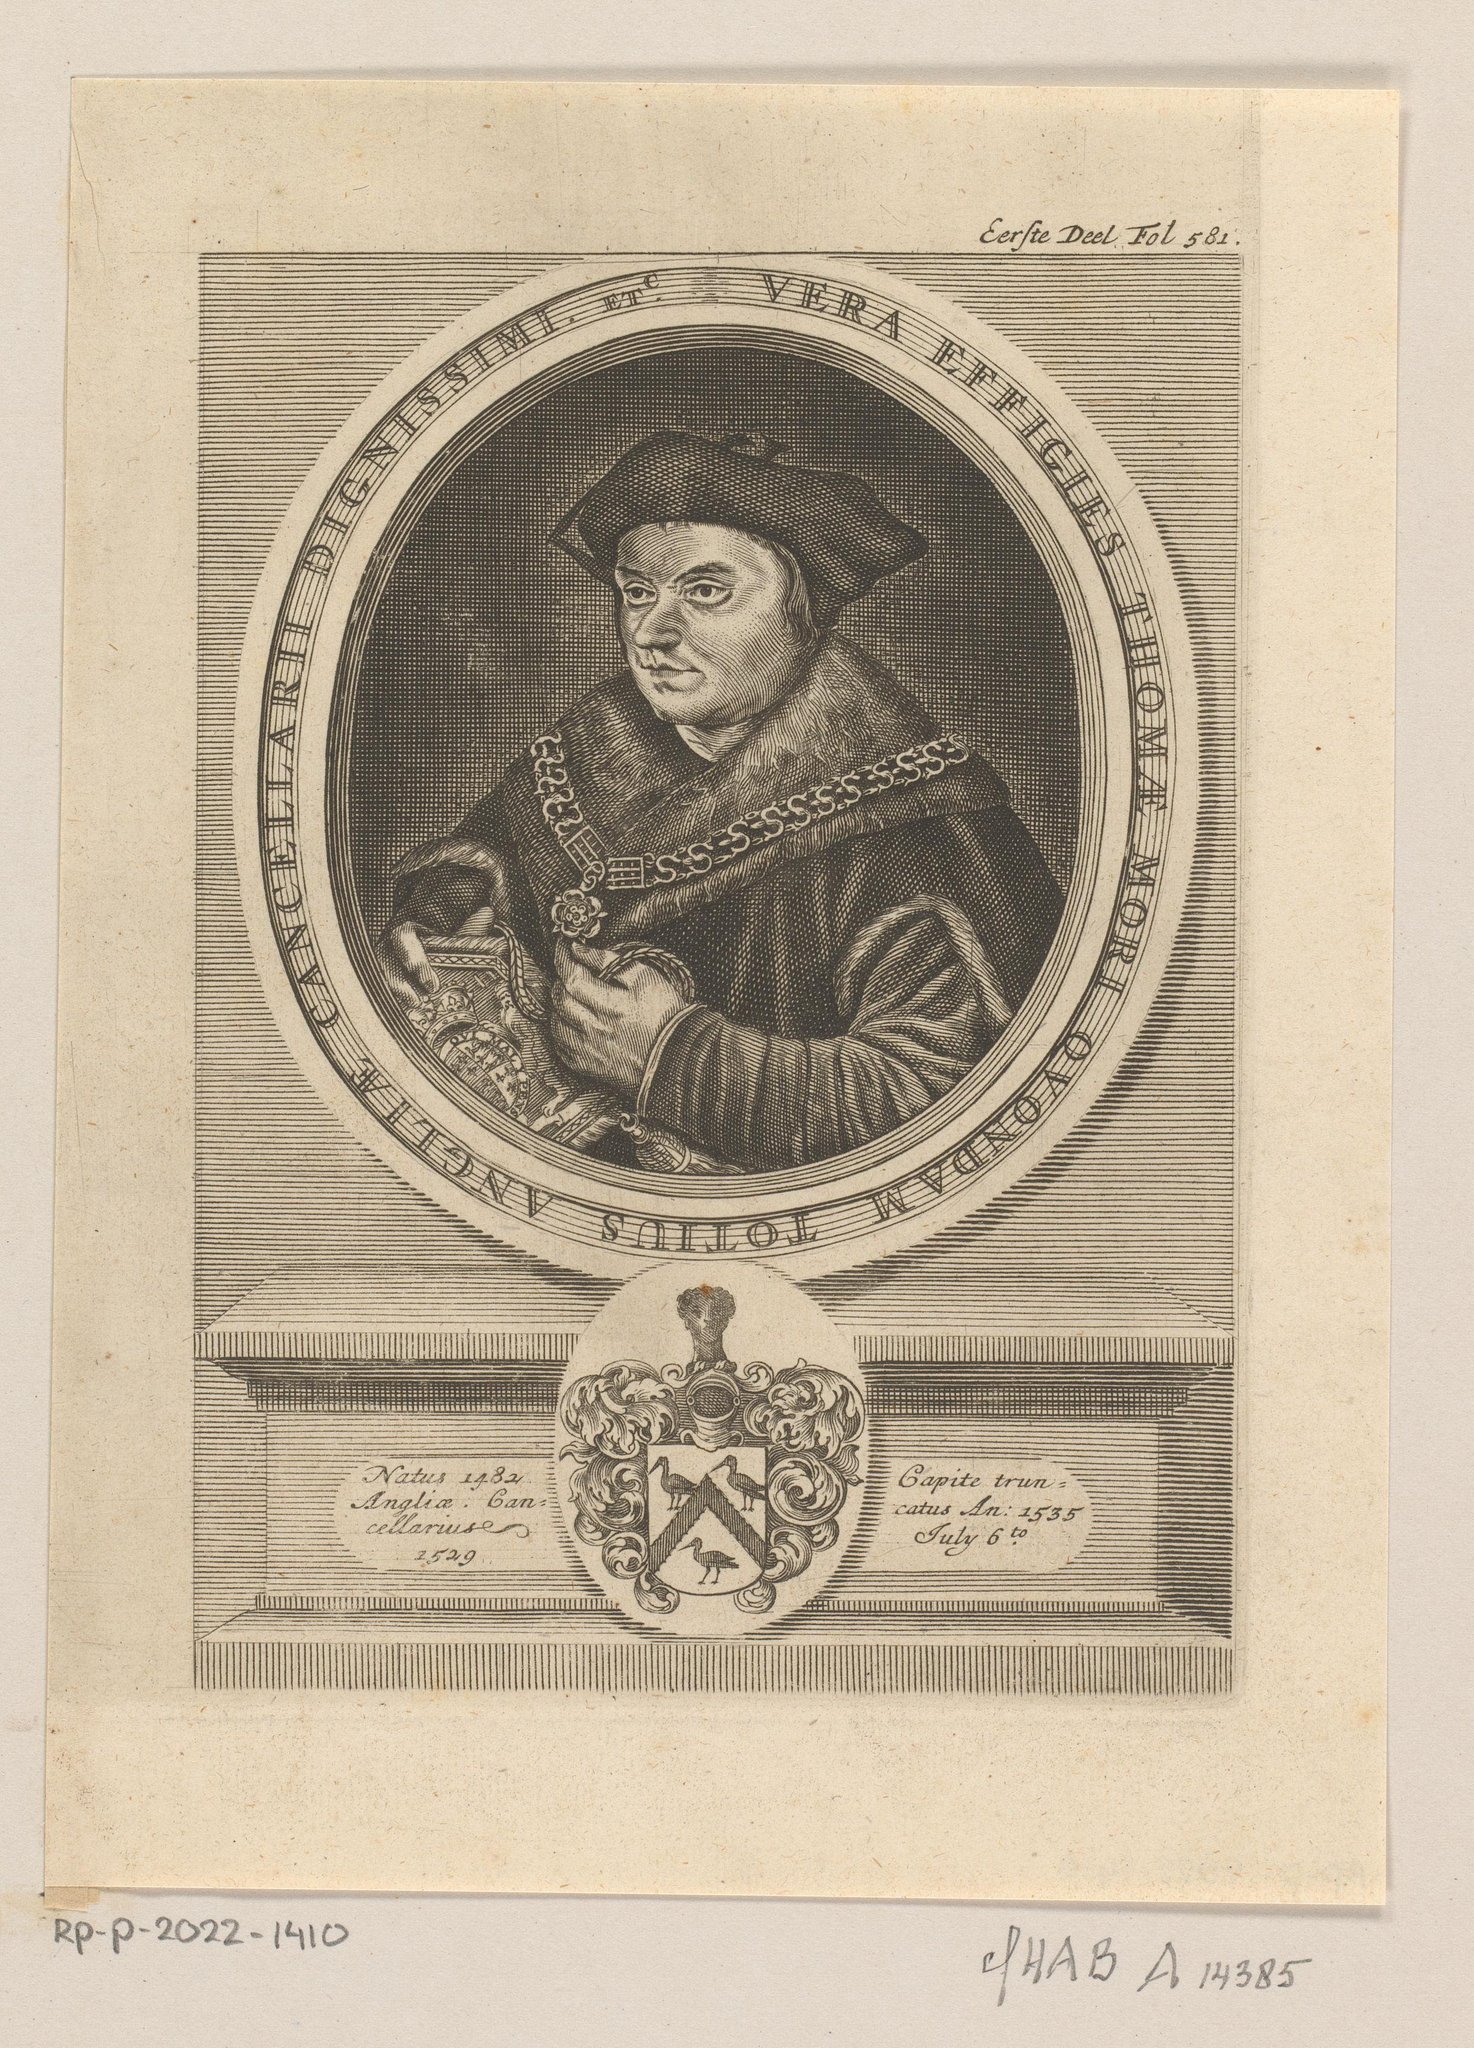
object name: book illustration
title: Portret van Thomas More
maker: Anonymous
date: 1680-1780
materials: paper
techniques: engraving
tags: london, scholar, philosopher, historical persons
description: Komt ook voor in: Burnet, Gilbert. Histoire de la Reformation de l'Eglise d'Angleterre (...). Amsterdam: Abraham Wolfgang, 1687.